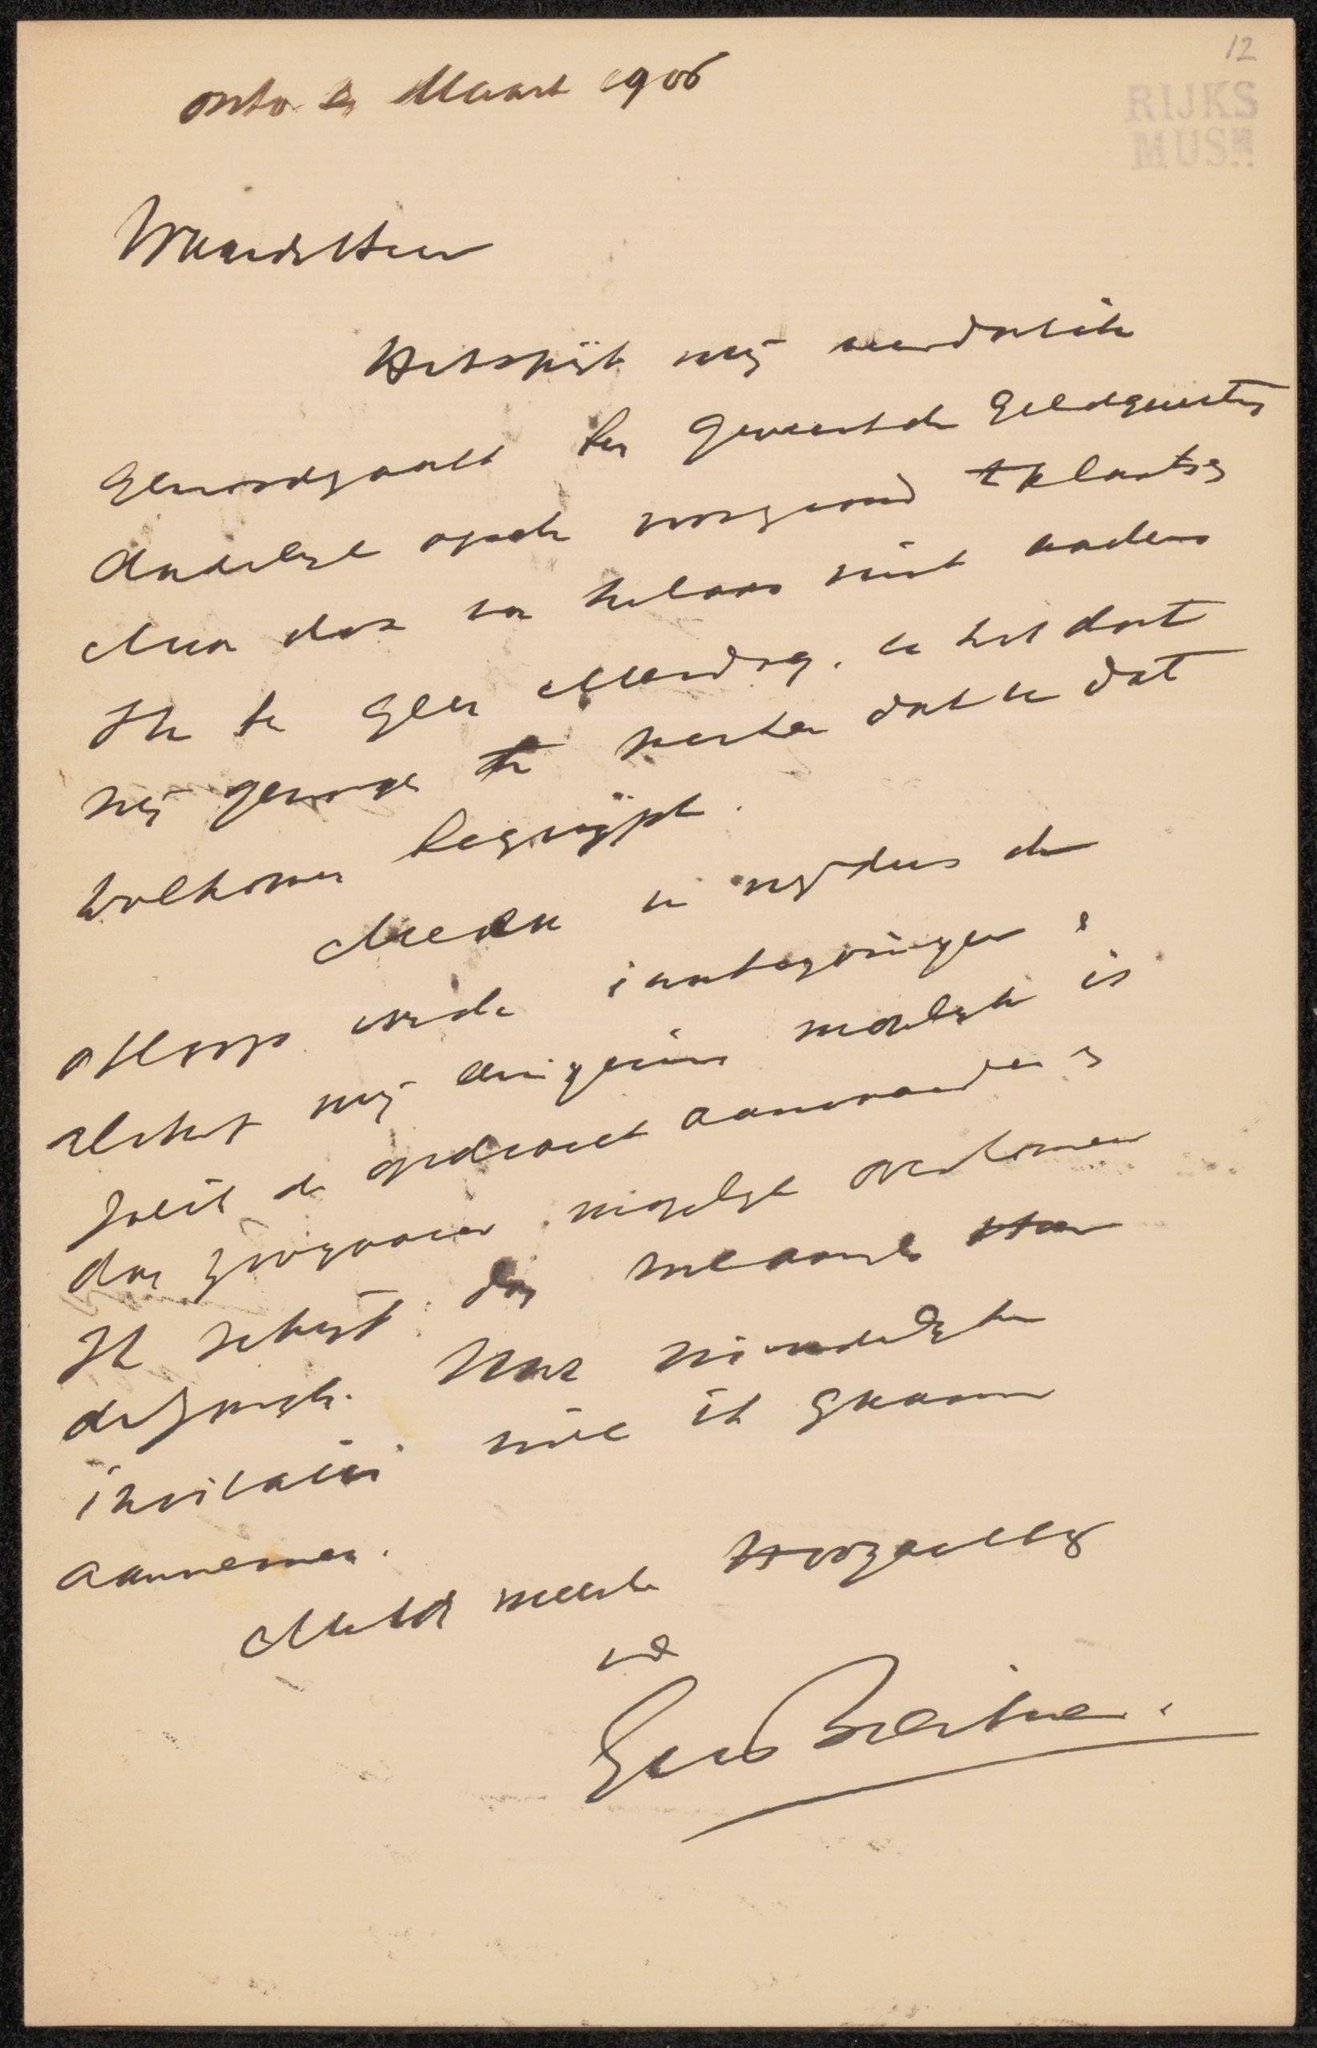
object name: letter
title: Brief aan Pieter Haverkorn van Rijsewijk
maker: george hendrik breitner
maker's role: draughtsman, painter, print maker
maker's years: 1857-1923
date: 1903-1906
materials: ink, paper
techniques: pen, writing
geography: amsterdam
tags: pieter haverkorn van rijsewijk, painting (including book-illumination, miniature-painting)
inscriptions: collector's mark: Lugt 2166